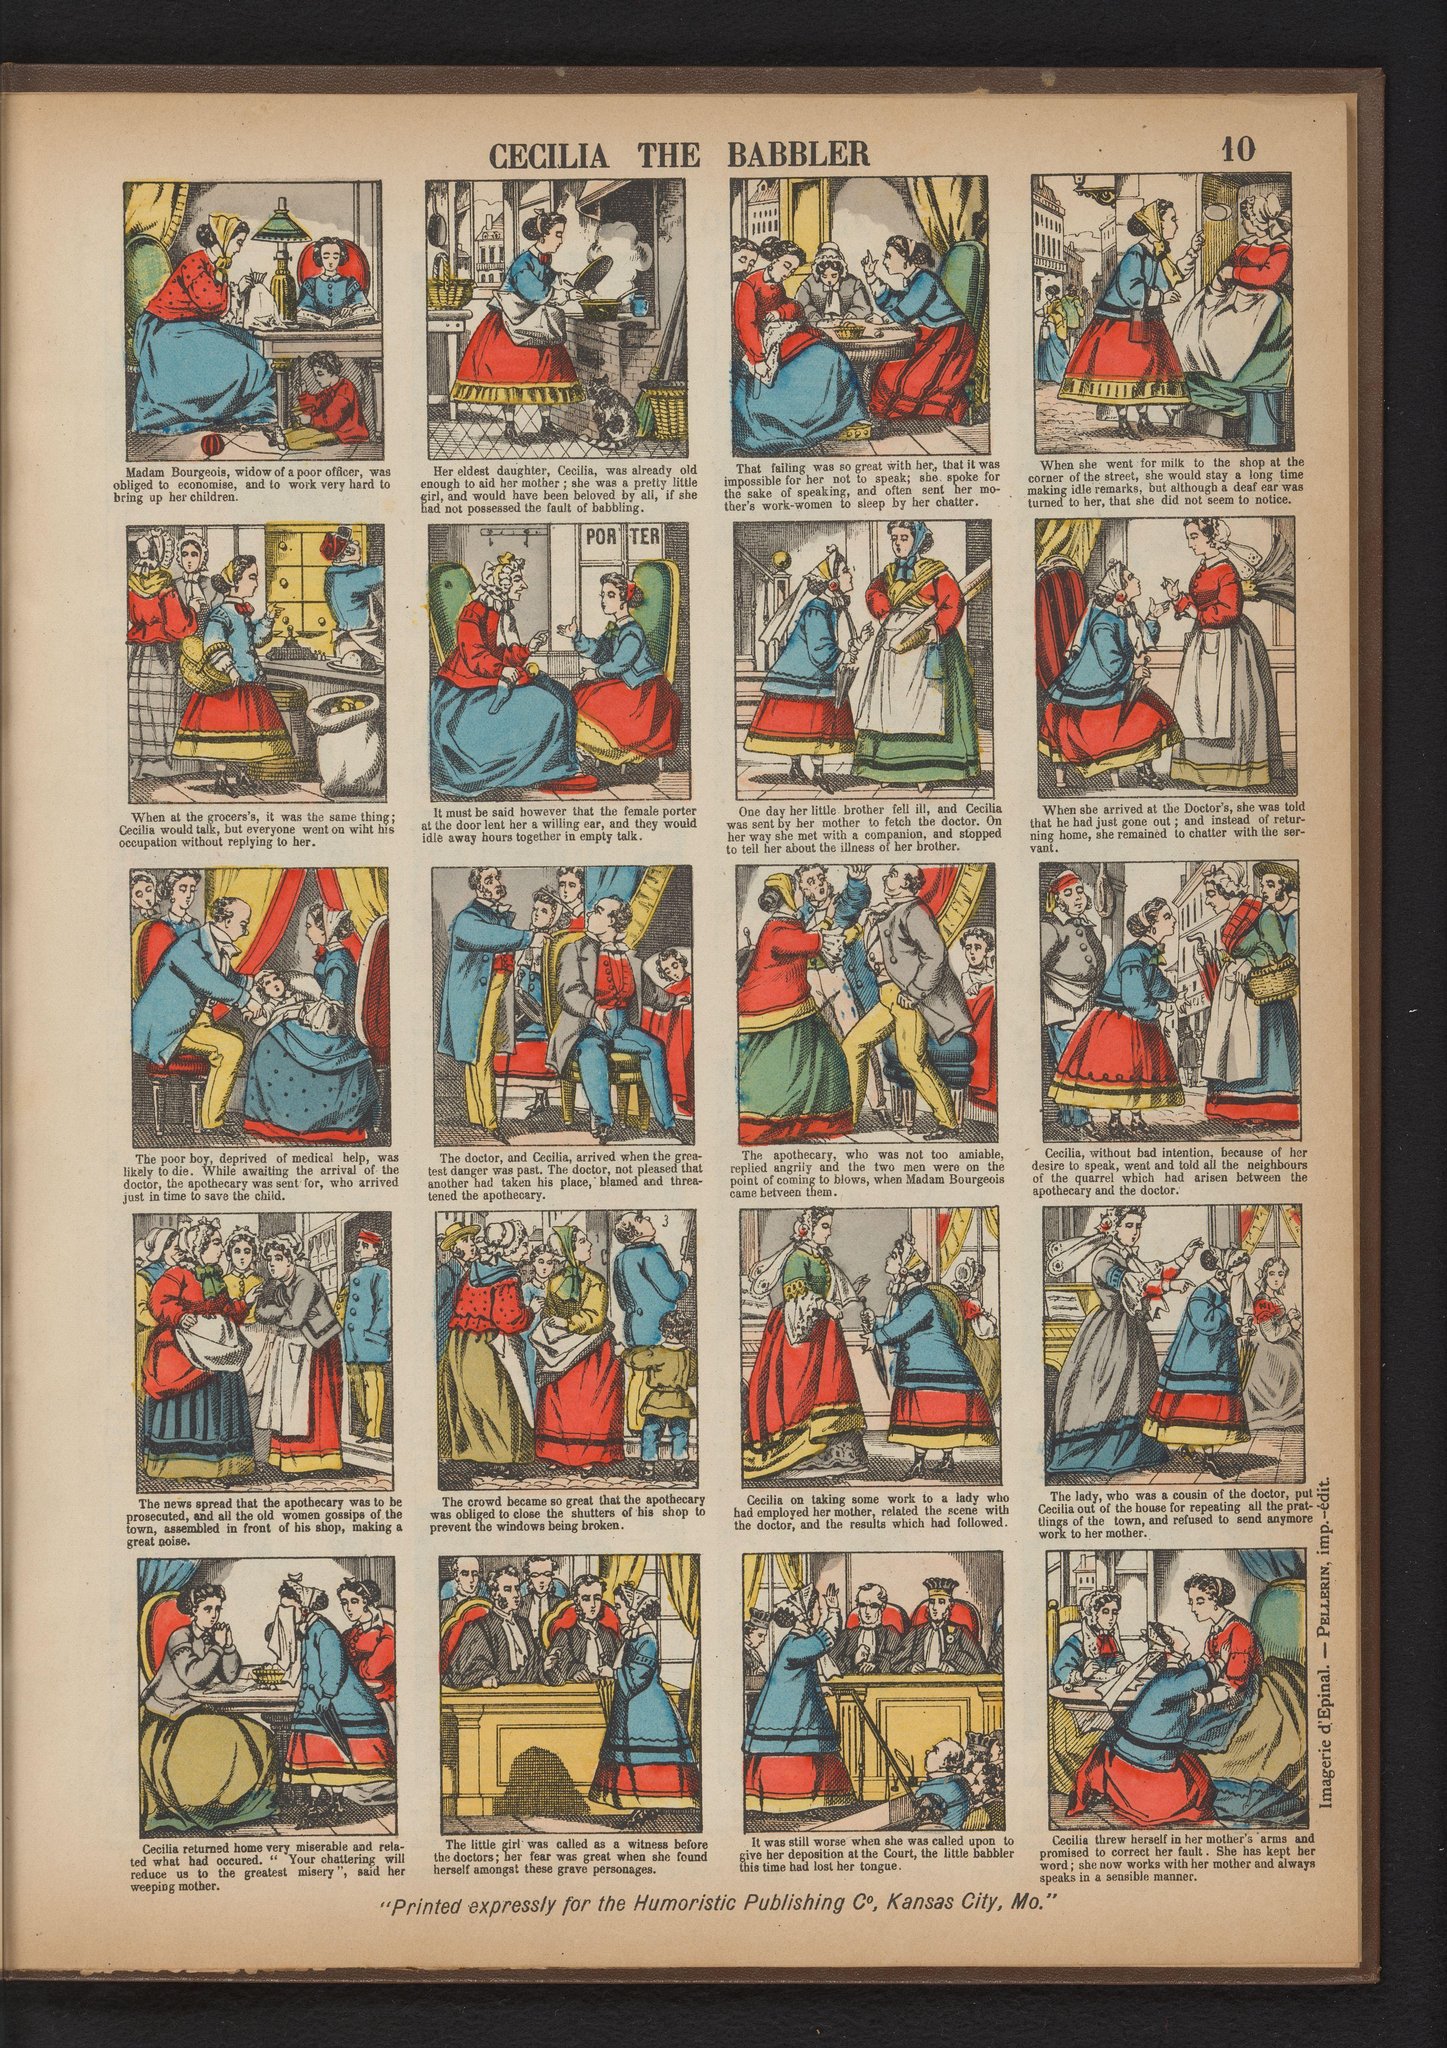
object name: popular print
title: Cecilia the babbler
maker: Anonymous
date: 1893-1894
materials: paper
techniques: colour, letterpress printing, lithograph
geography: epinal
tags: girl (child between toddler and youth), conversation, dialogue; conversation piece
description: Blad met zestien voorstellingen over Cecilia die problemen veroorzaakt door telkens te lang te kletsen. Onder elke voorstelling een onderschrift in het Engels. Deze prent maakt deel uit van een album.